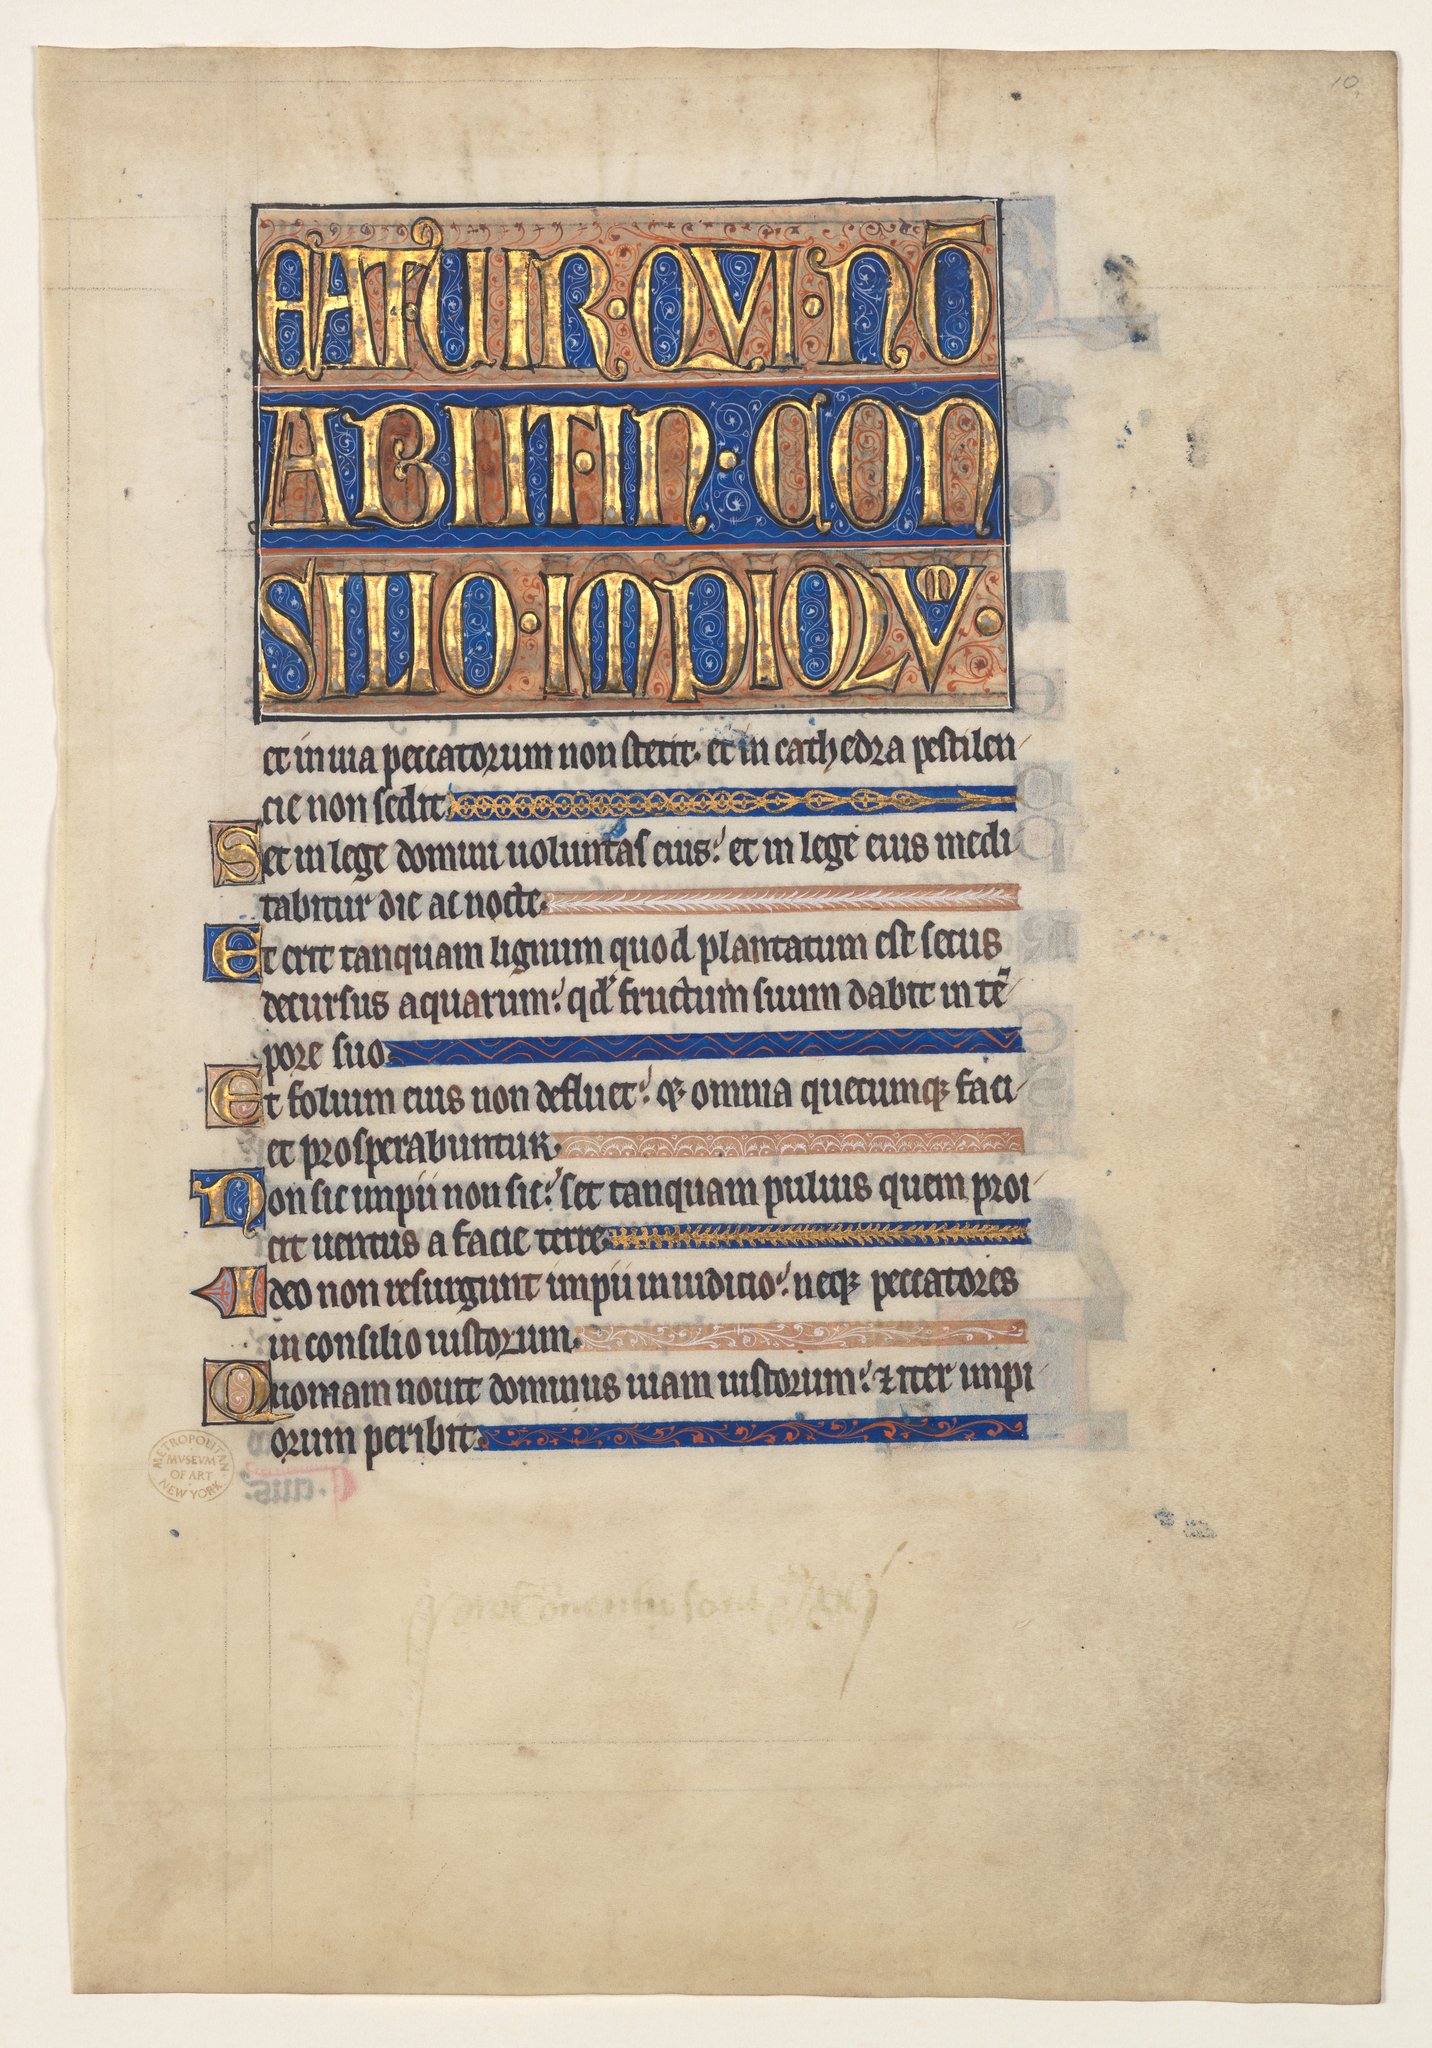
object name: psalter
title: Manuscript Leaf from a Royal Psalter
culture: british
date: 1250-1270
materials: gold, parchment, paint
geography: england